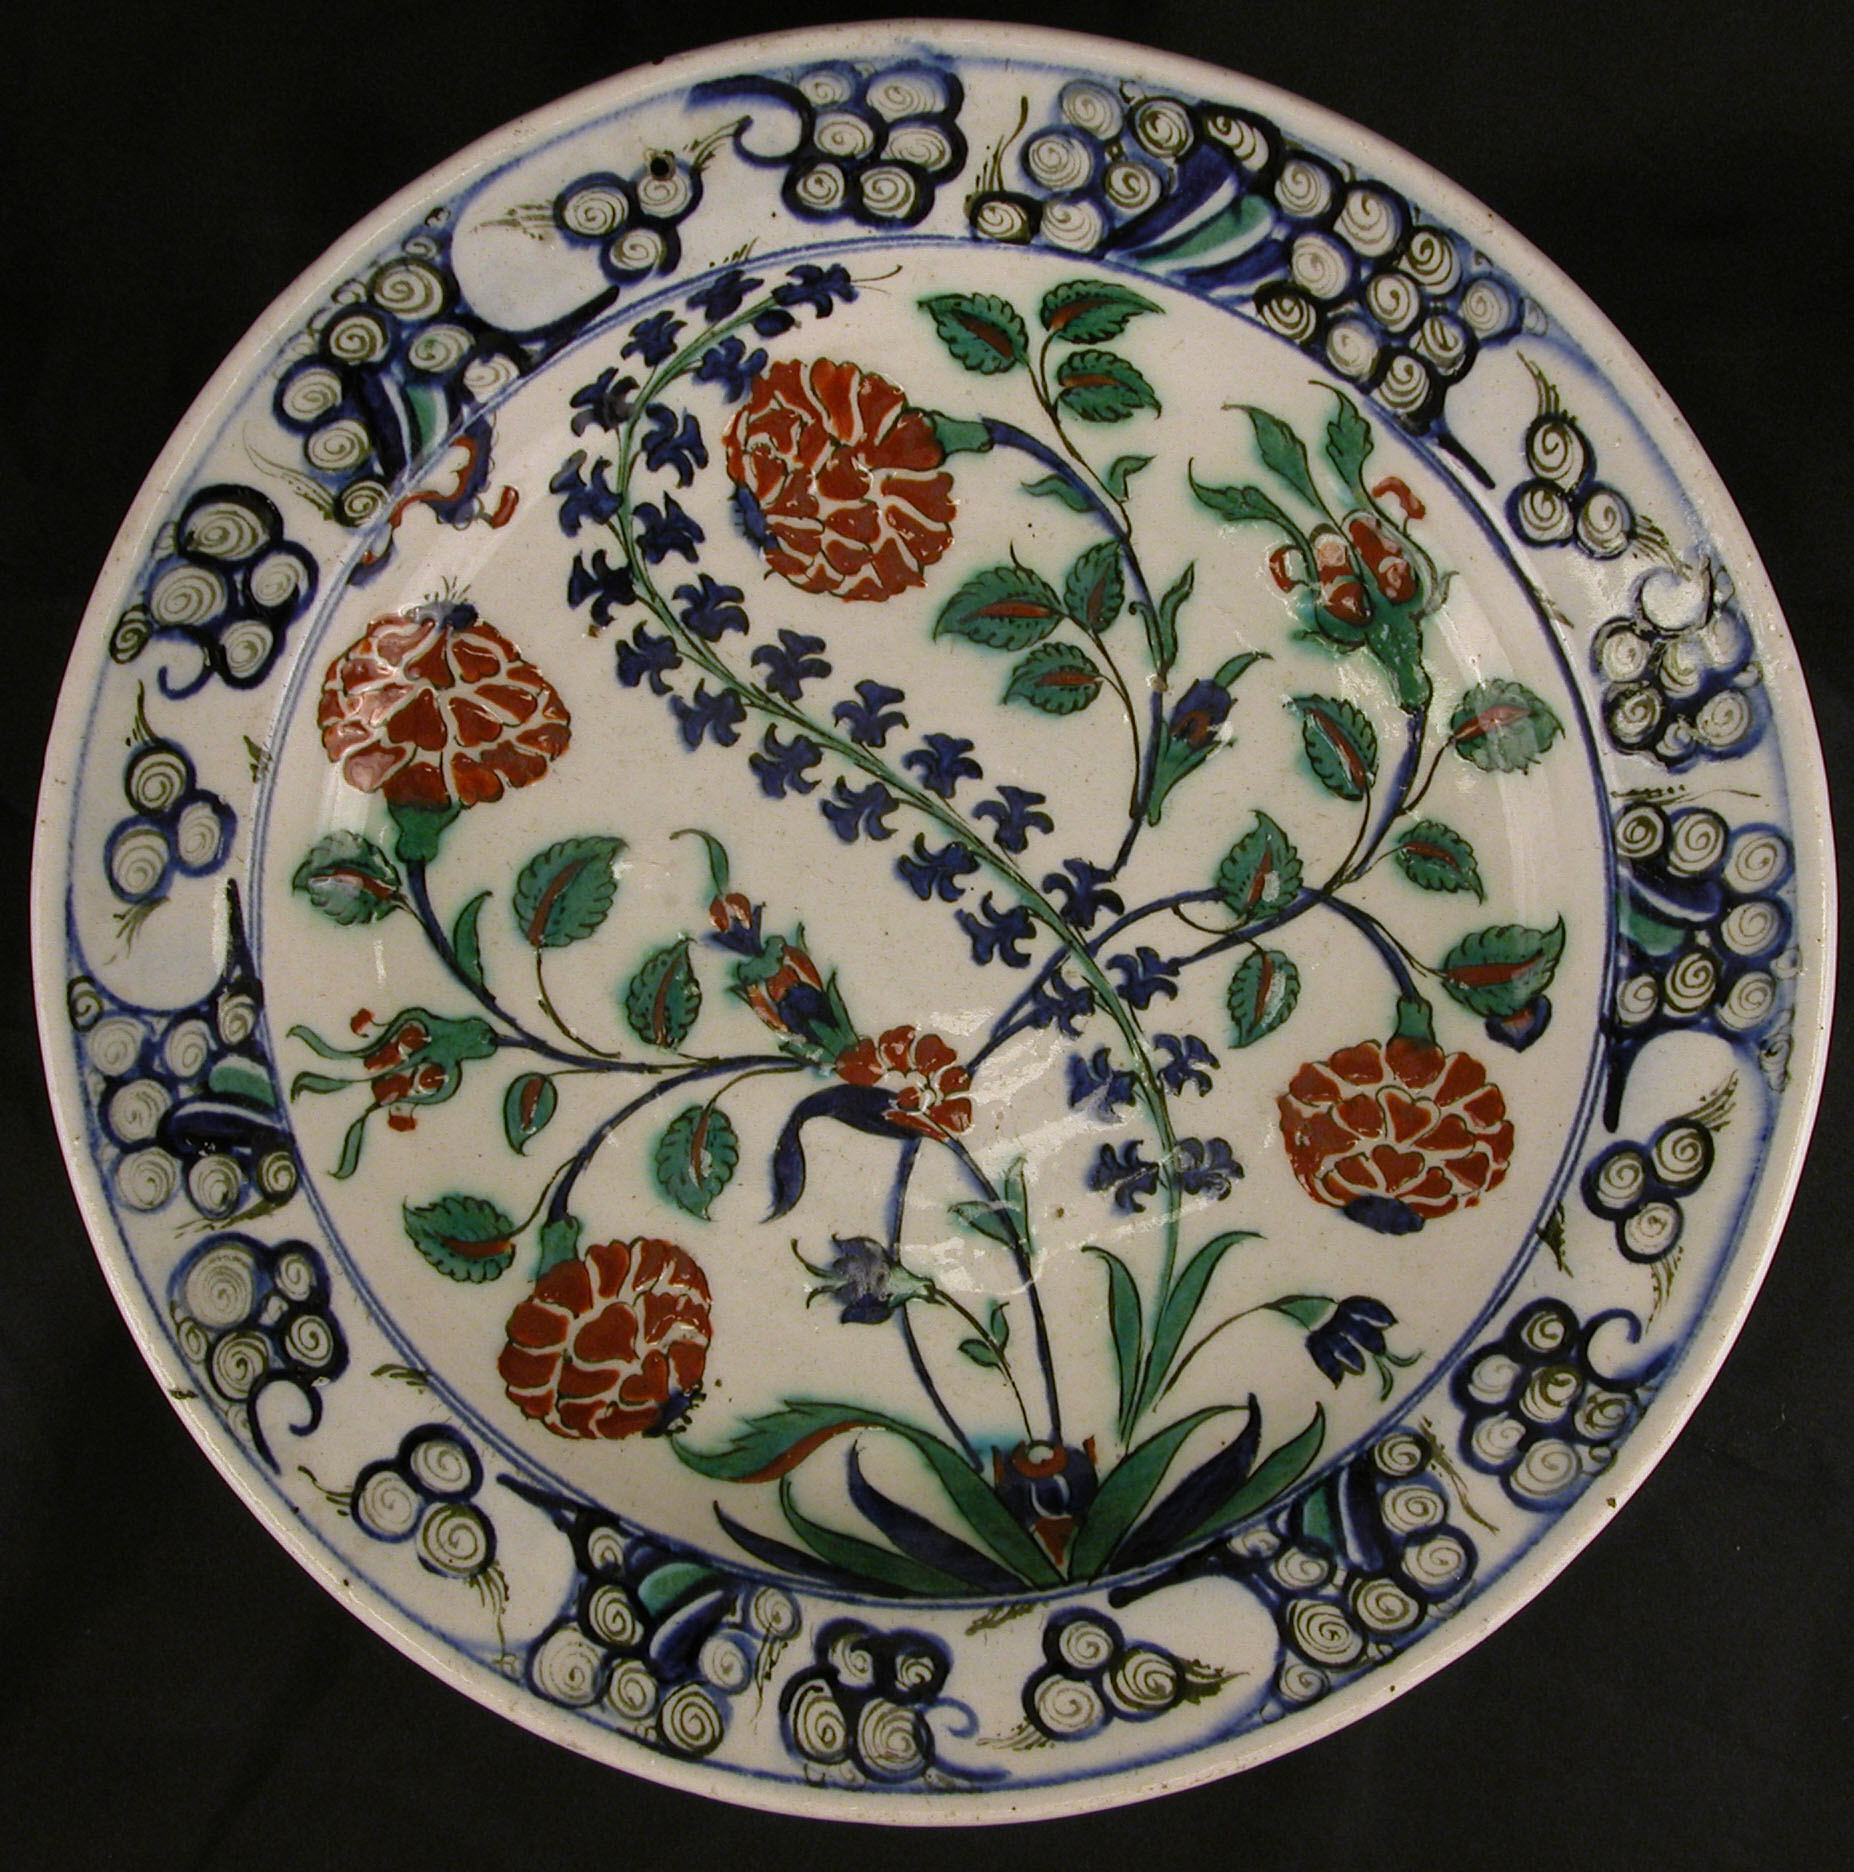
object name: dish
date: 1601-1633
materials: glaze, stonepaste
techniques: painting, polychrome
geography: turkey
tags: flowers,leaves